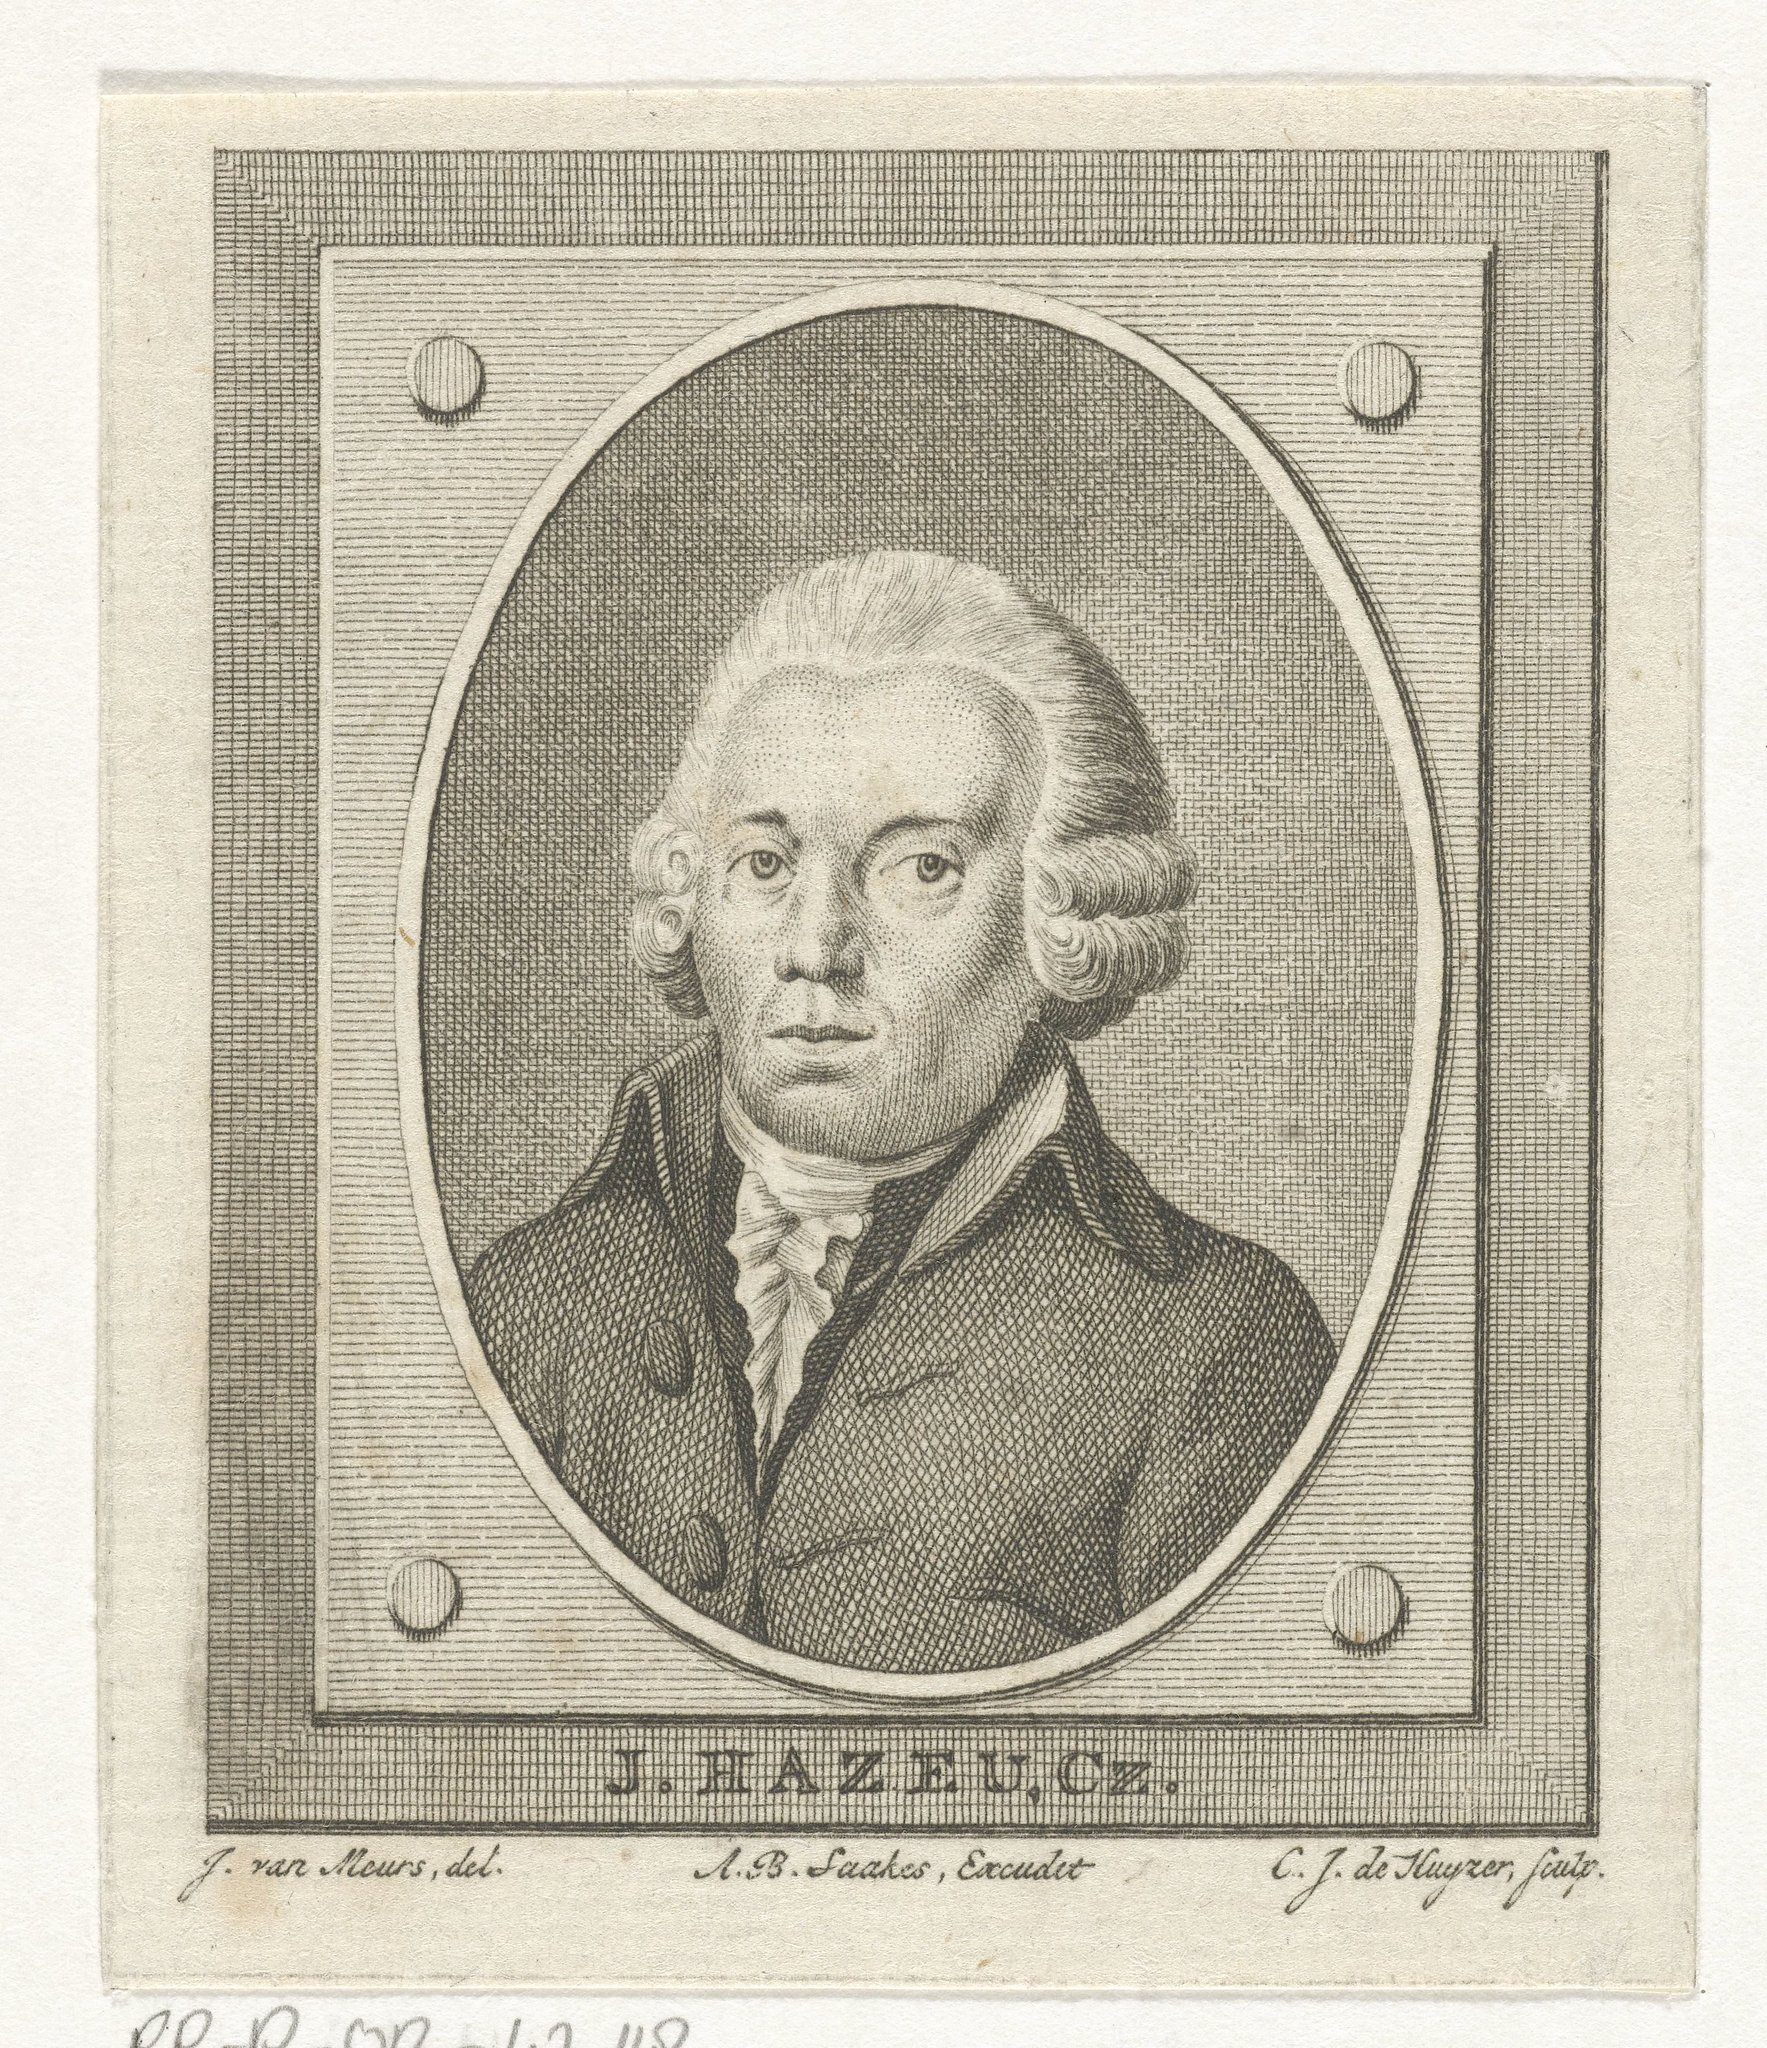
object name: print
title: Portret van Johannes Hazeu Cornelisz.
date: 1763-1804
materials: paper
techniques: engraving, etching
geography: amsterdam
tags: haarlem, johannes hazeu cornelisz.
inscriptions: collector's mark: Lugt 2228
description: Busteportret van Johannes Hazeu Cornelisz. naar links in een ovale lijst.